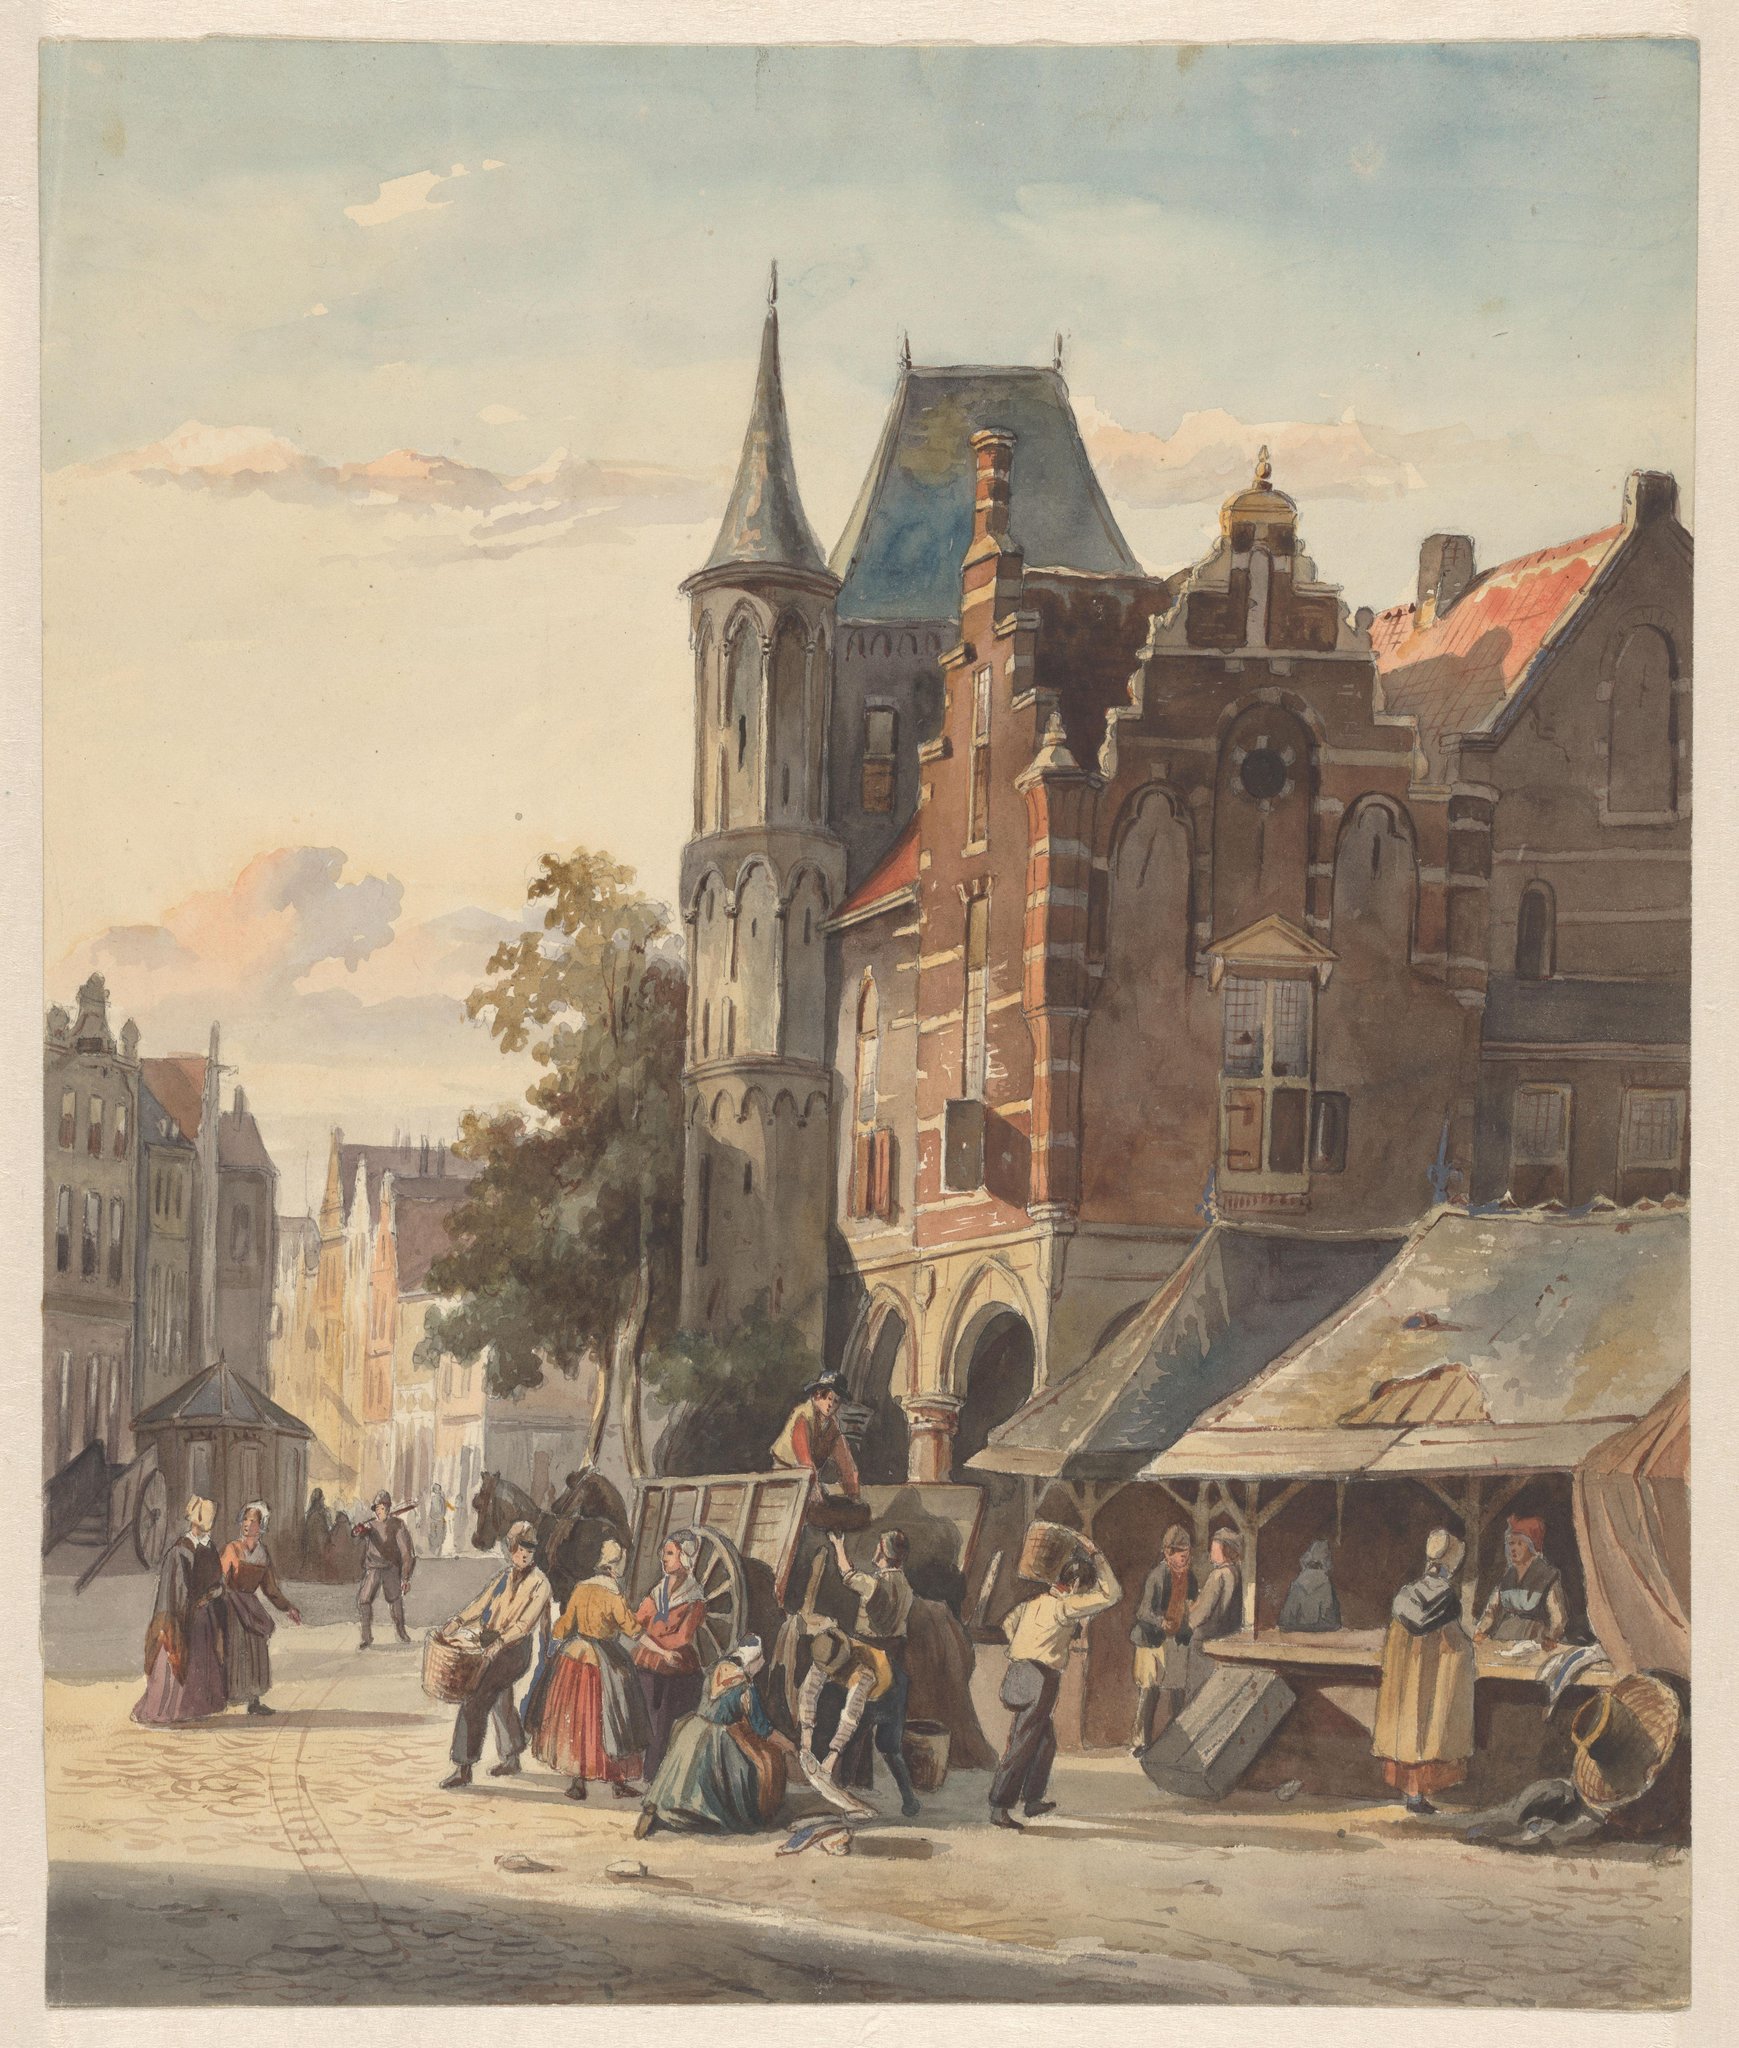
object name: drawing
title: Stadsgezicht met markt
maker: georgius heerebaart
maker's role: draughtsman, painter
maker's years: 1829-1915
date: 1827-1871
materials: paint, paper, pencil, watercolor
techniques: brush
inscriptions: initials: ‘G:H:’, annotation: ‘Groten in den Dag van Den Lijst’, number: ‘00:496’